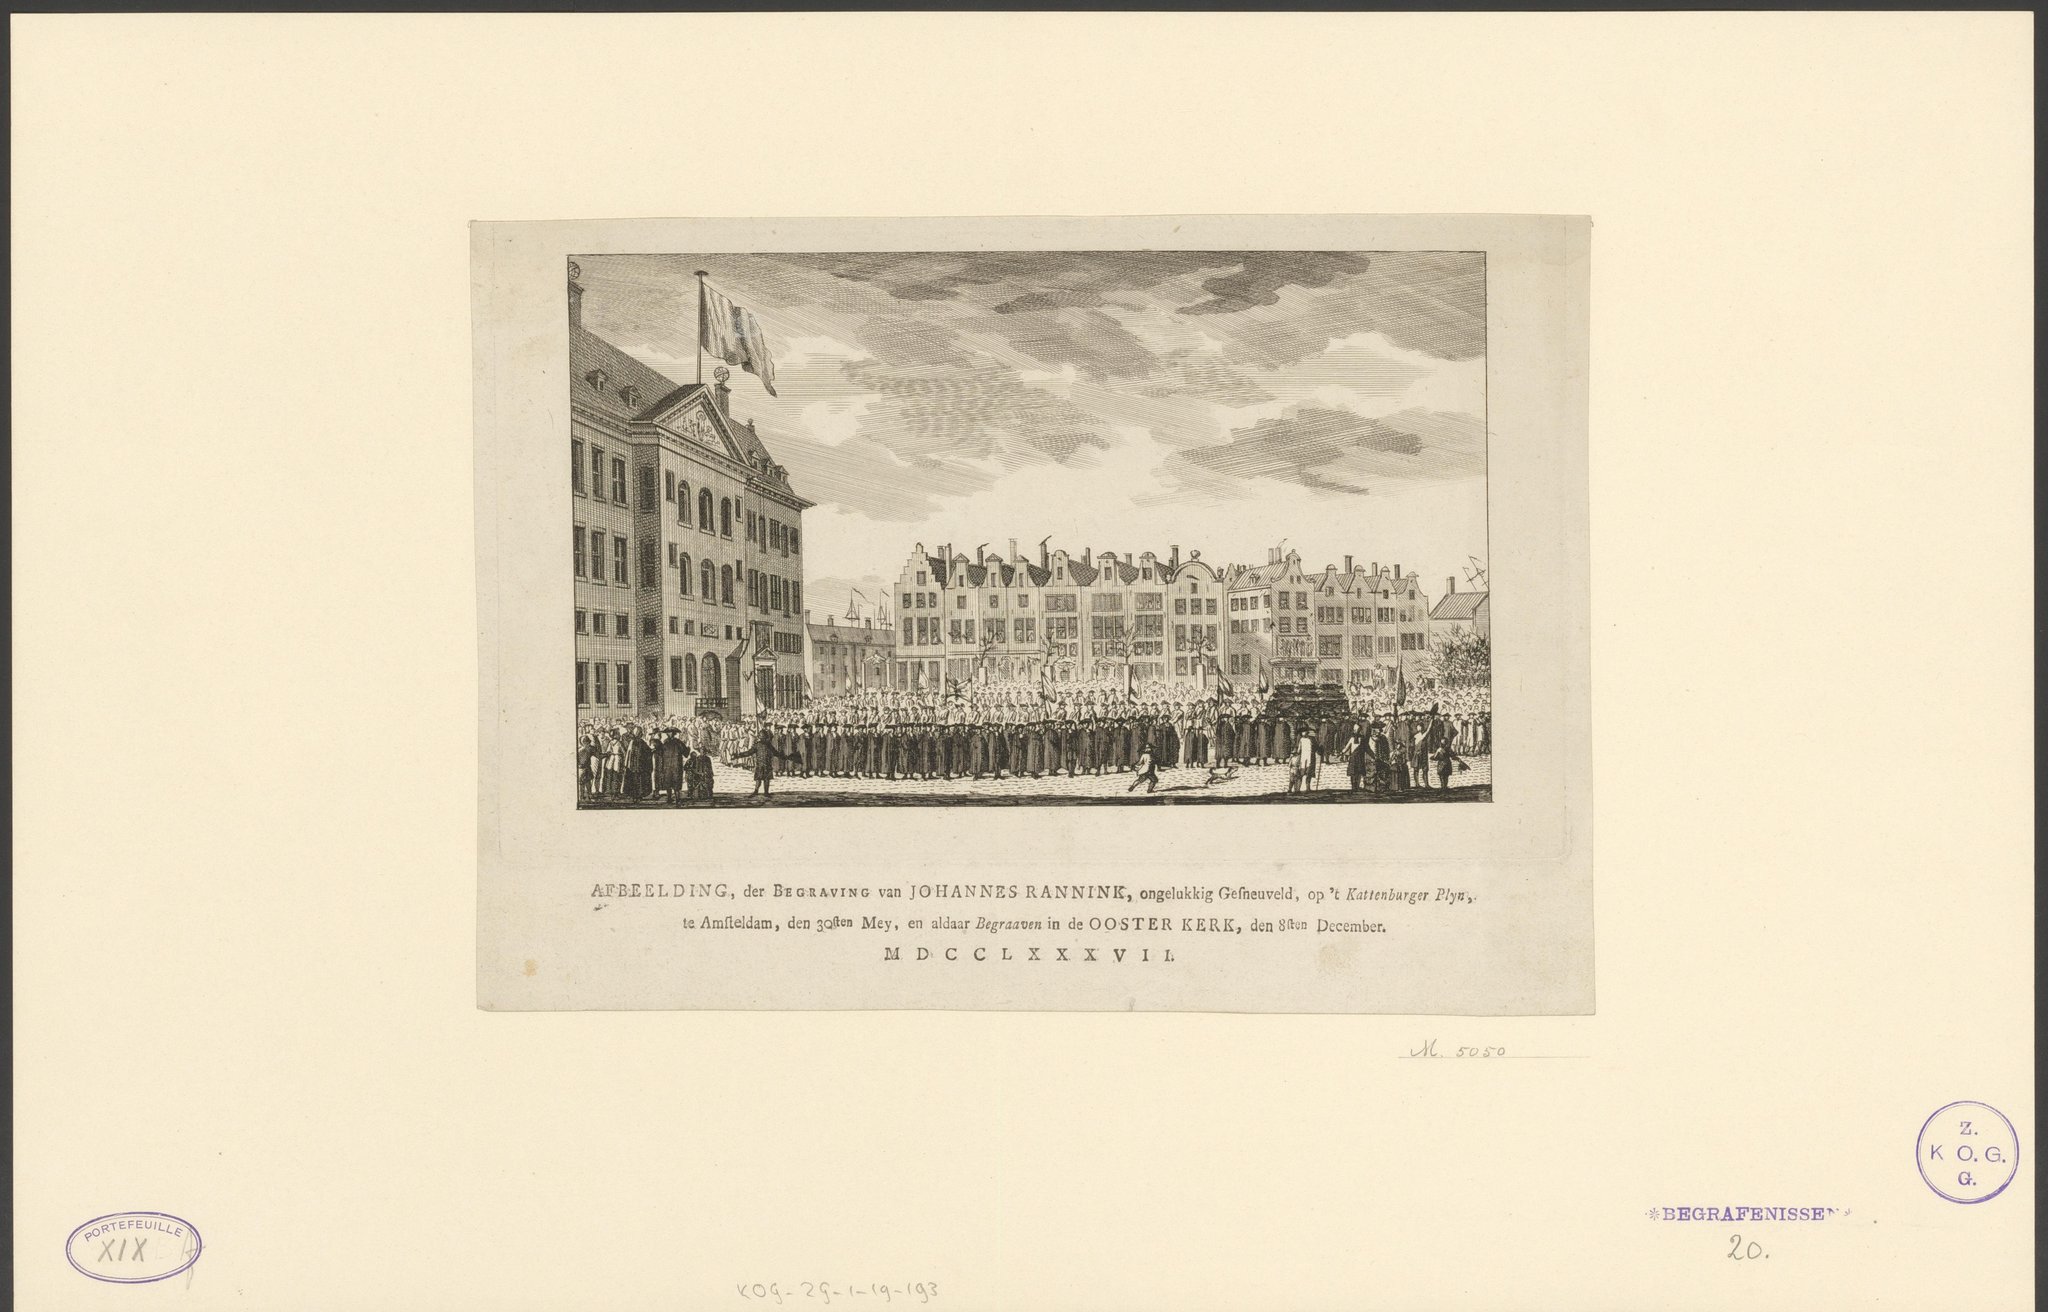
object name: print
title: Begrafenis van Johannes Rannink, 1747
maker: Anonymous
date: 1787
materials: paper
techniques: engraving, etching, letterpress printing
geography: northern netherlands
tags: cortege, funeral procession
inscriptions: collector's mark, collector's mark: Lugt 1641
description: Begrafenis op 8 december 1787 van Johannes Rannink, aanvoerder van de bijltjes, de opstandige Oranjegezinde Amsterdamse scheepstimmerlieden die op het eiland Kattenburg in opstand kwamen tegen het patriotse stadsbestuur, en die sneuvelde op 30 mei 1787. Gezicht op de begrafenisstoet op het Kattenburgerplein. Onderwerpsrubrieken binnen de Atlas Zeden en Gewoonten: Des Menschen Begin, Midden en Einde. Begrafenissen, lijkstaties.